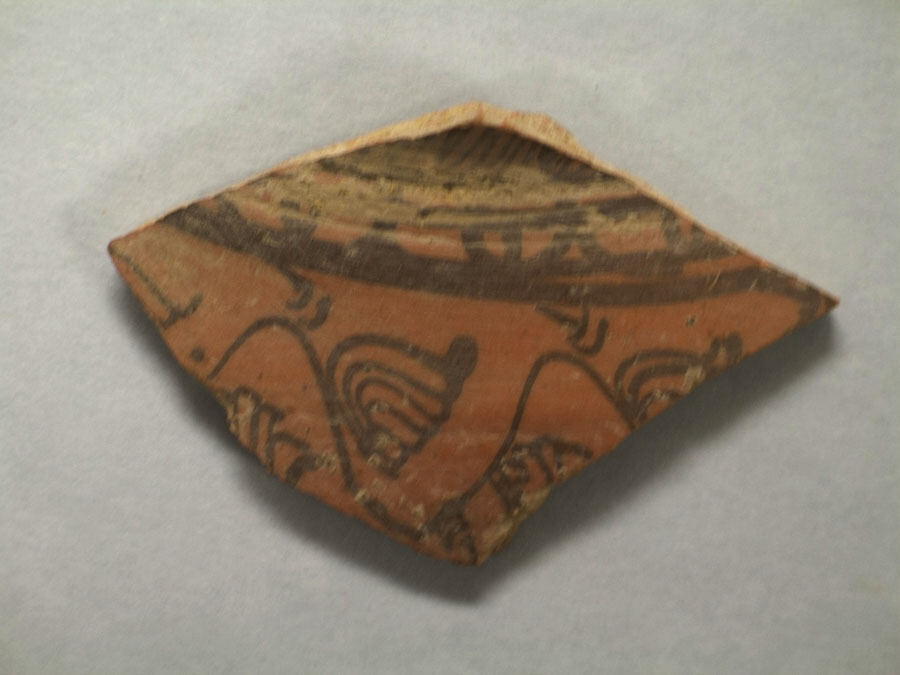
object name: shard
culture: pakistani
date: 301-500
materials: terracotta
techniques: painting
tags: gandhara